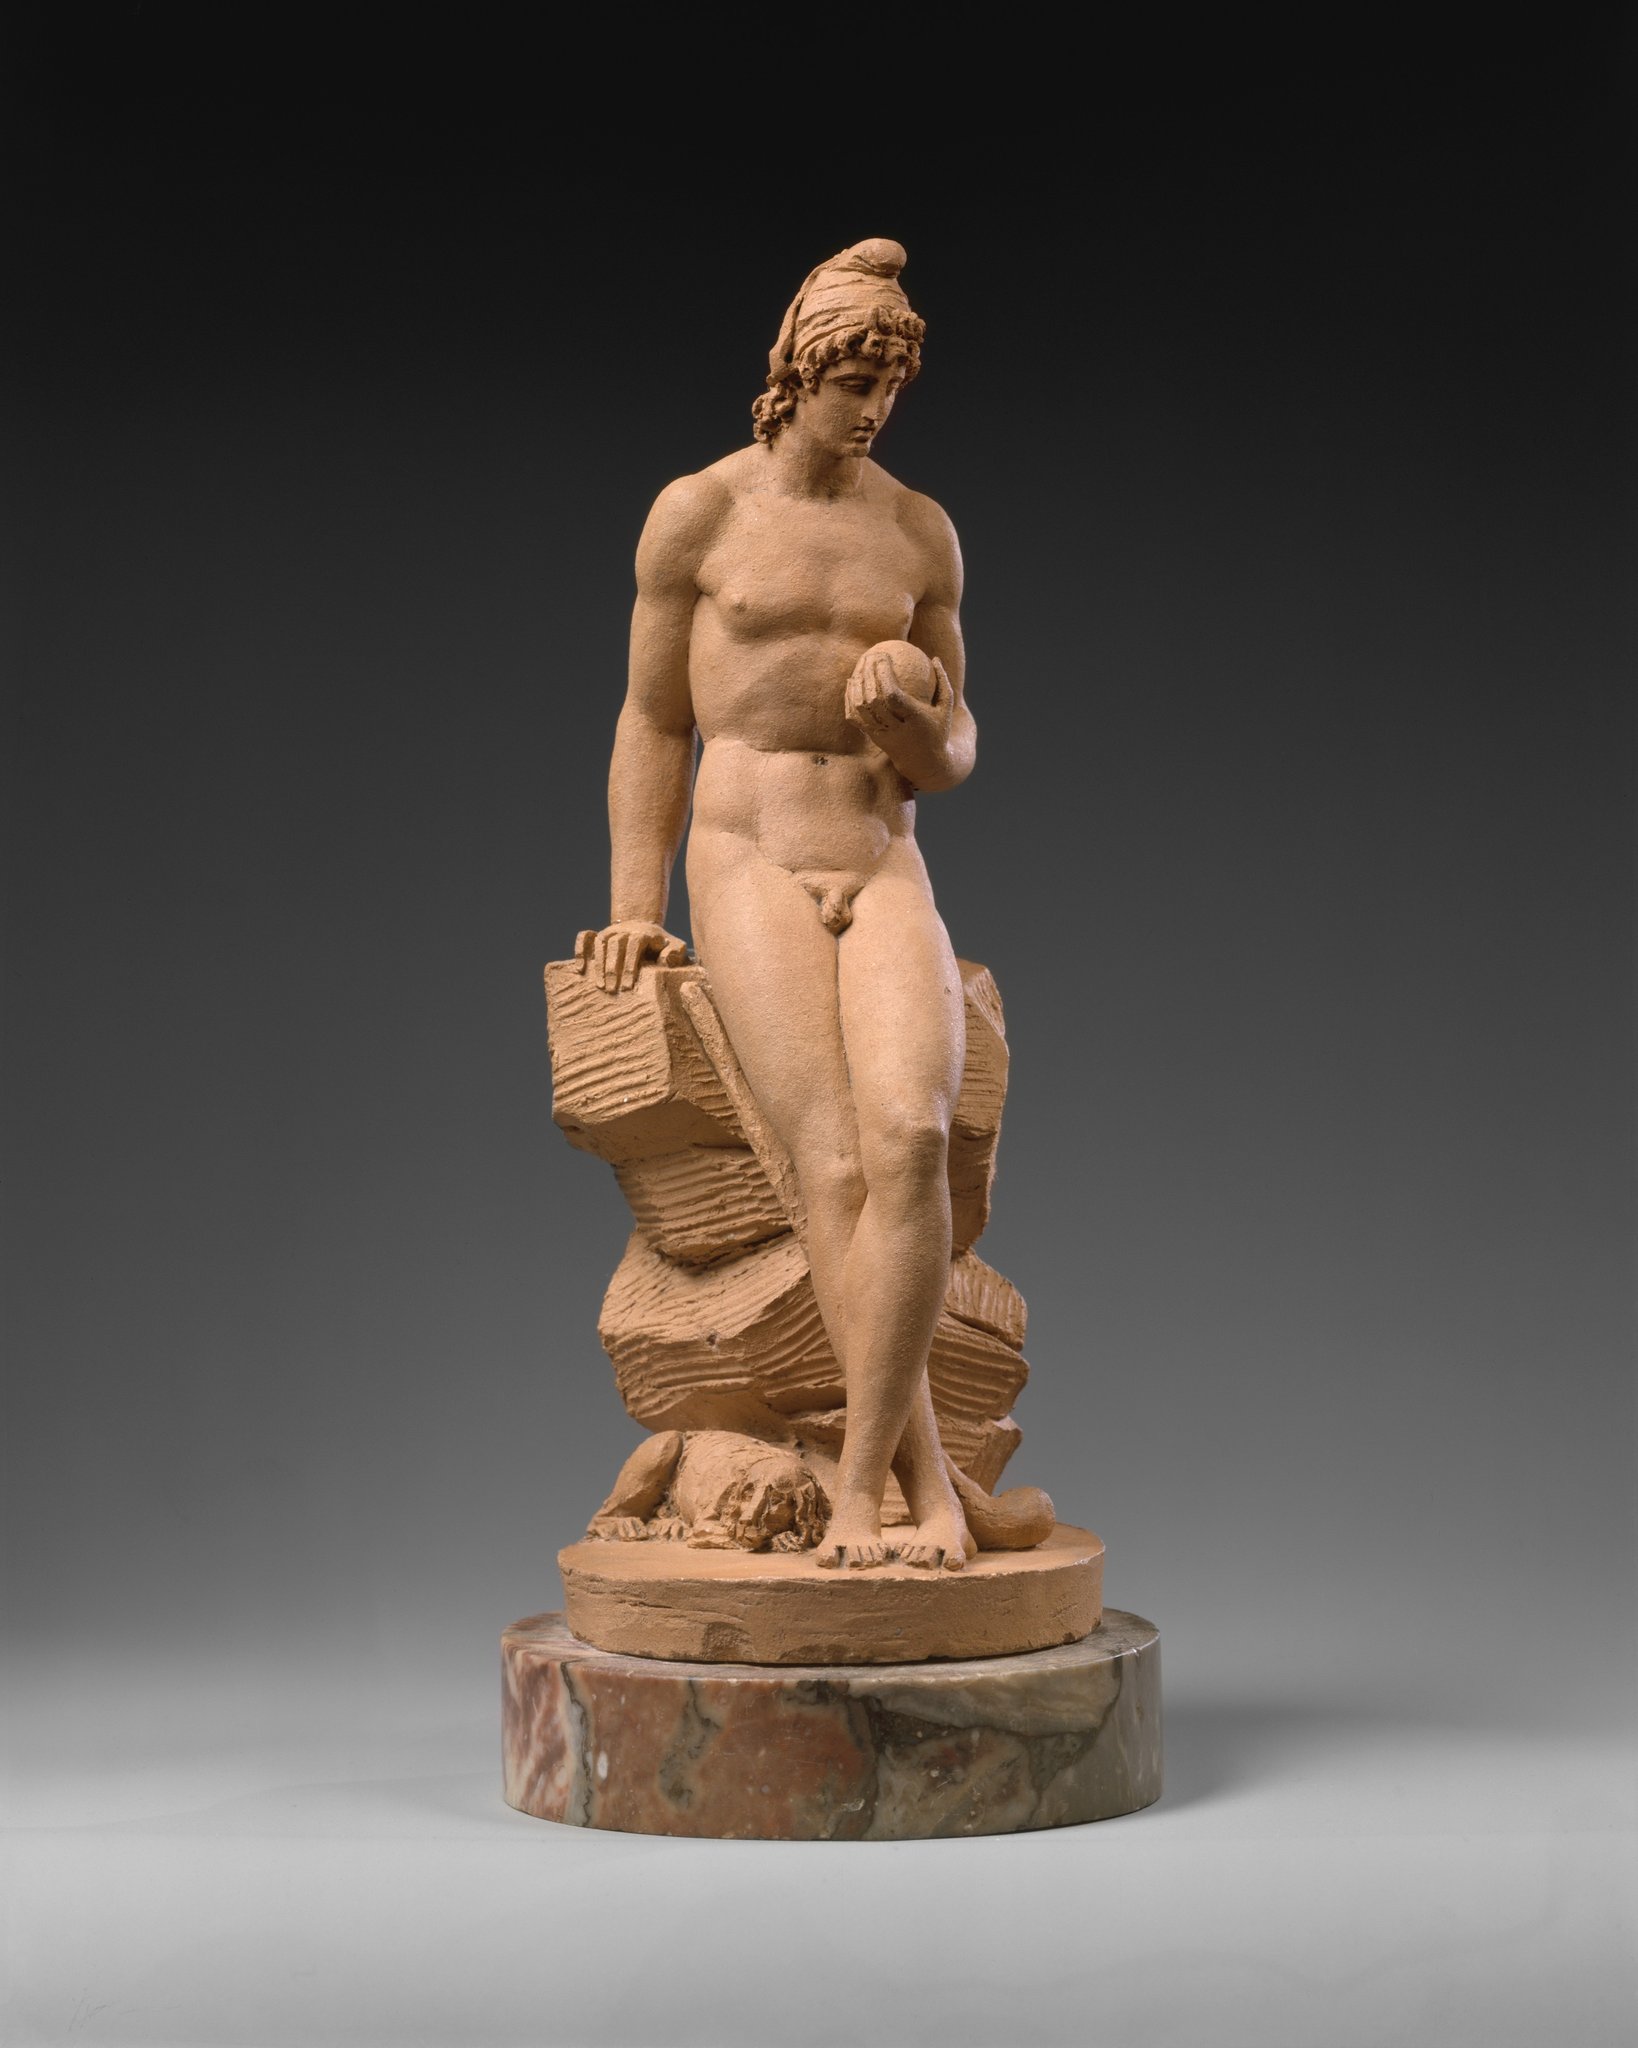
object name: statuette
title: Paris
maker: jacques-edmé dumont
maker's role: artist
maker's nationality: french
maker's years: 1761-1844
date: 1795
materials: marble, terracotta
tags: male nudes,dogs